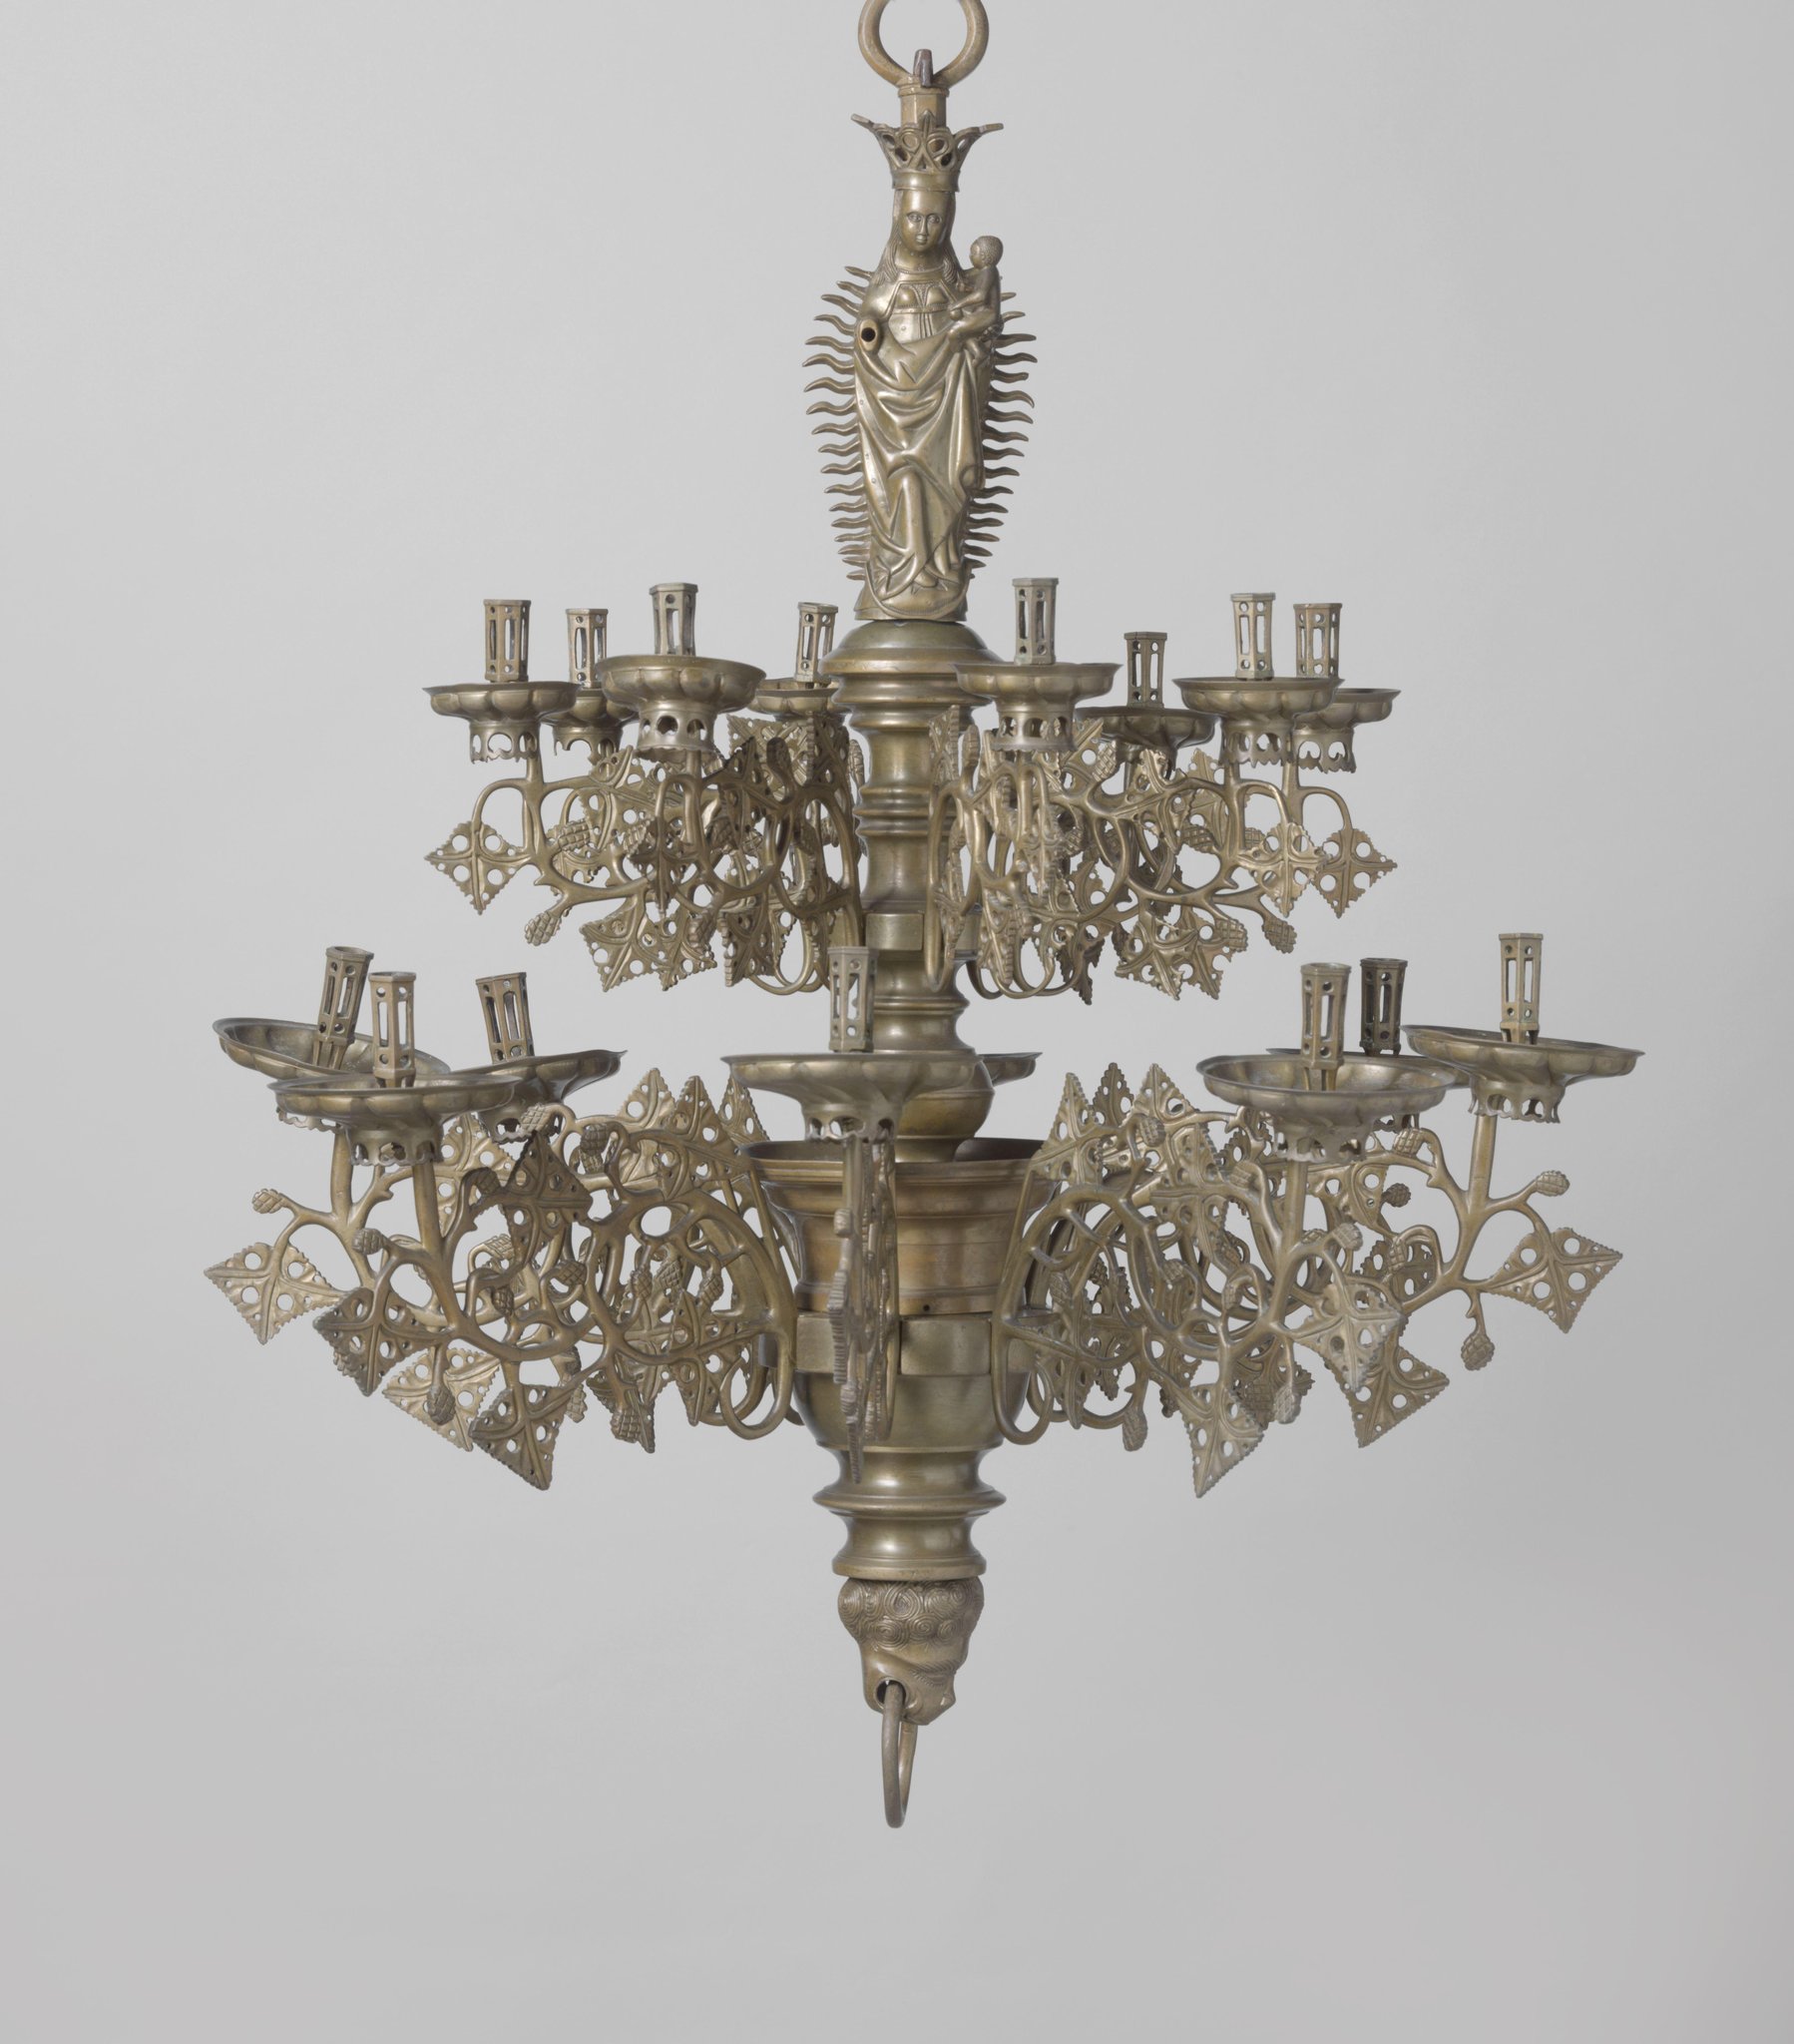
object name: chandelier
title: Arm met kaarsenhouder van kaarsenkroon van twee hoogten met ieder acht armen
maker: Anonymous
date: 1525-1550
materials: brass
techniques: casting, screwed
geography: southern netherlands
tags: vine-tendril, leaf, mary standing (or half-length), the christ-child sitting on her arm (christ-child to mary's left)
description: Kaarsenarm behorende bij een kaarsenkroon van twee hoogten met Mariafiguur bovenaan. De arm is twee maal gebogen en is versierd met negen druiventrossen en vijf wingerdbladeren. De ronde vetvanger is aan de onderkant versierd met visblaasmotieven en heeft naar het midden toe een naar beneden uitstekende rand van kruisbloemen, die de plaatsing op de arm maskeert. De kaarsenhouder is zesvlakkig, opengewerkt, geplaatst op drie verticale stijlen, overgaande in een uitsteeksel met schroefdraad. Dit is de tweede arm van de onderste ring, genummerd met 7 ronde punten. De kaarsenhouder is genummerd met 2 diagonale inkepingen.